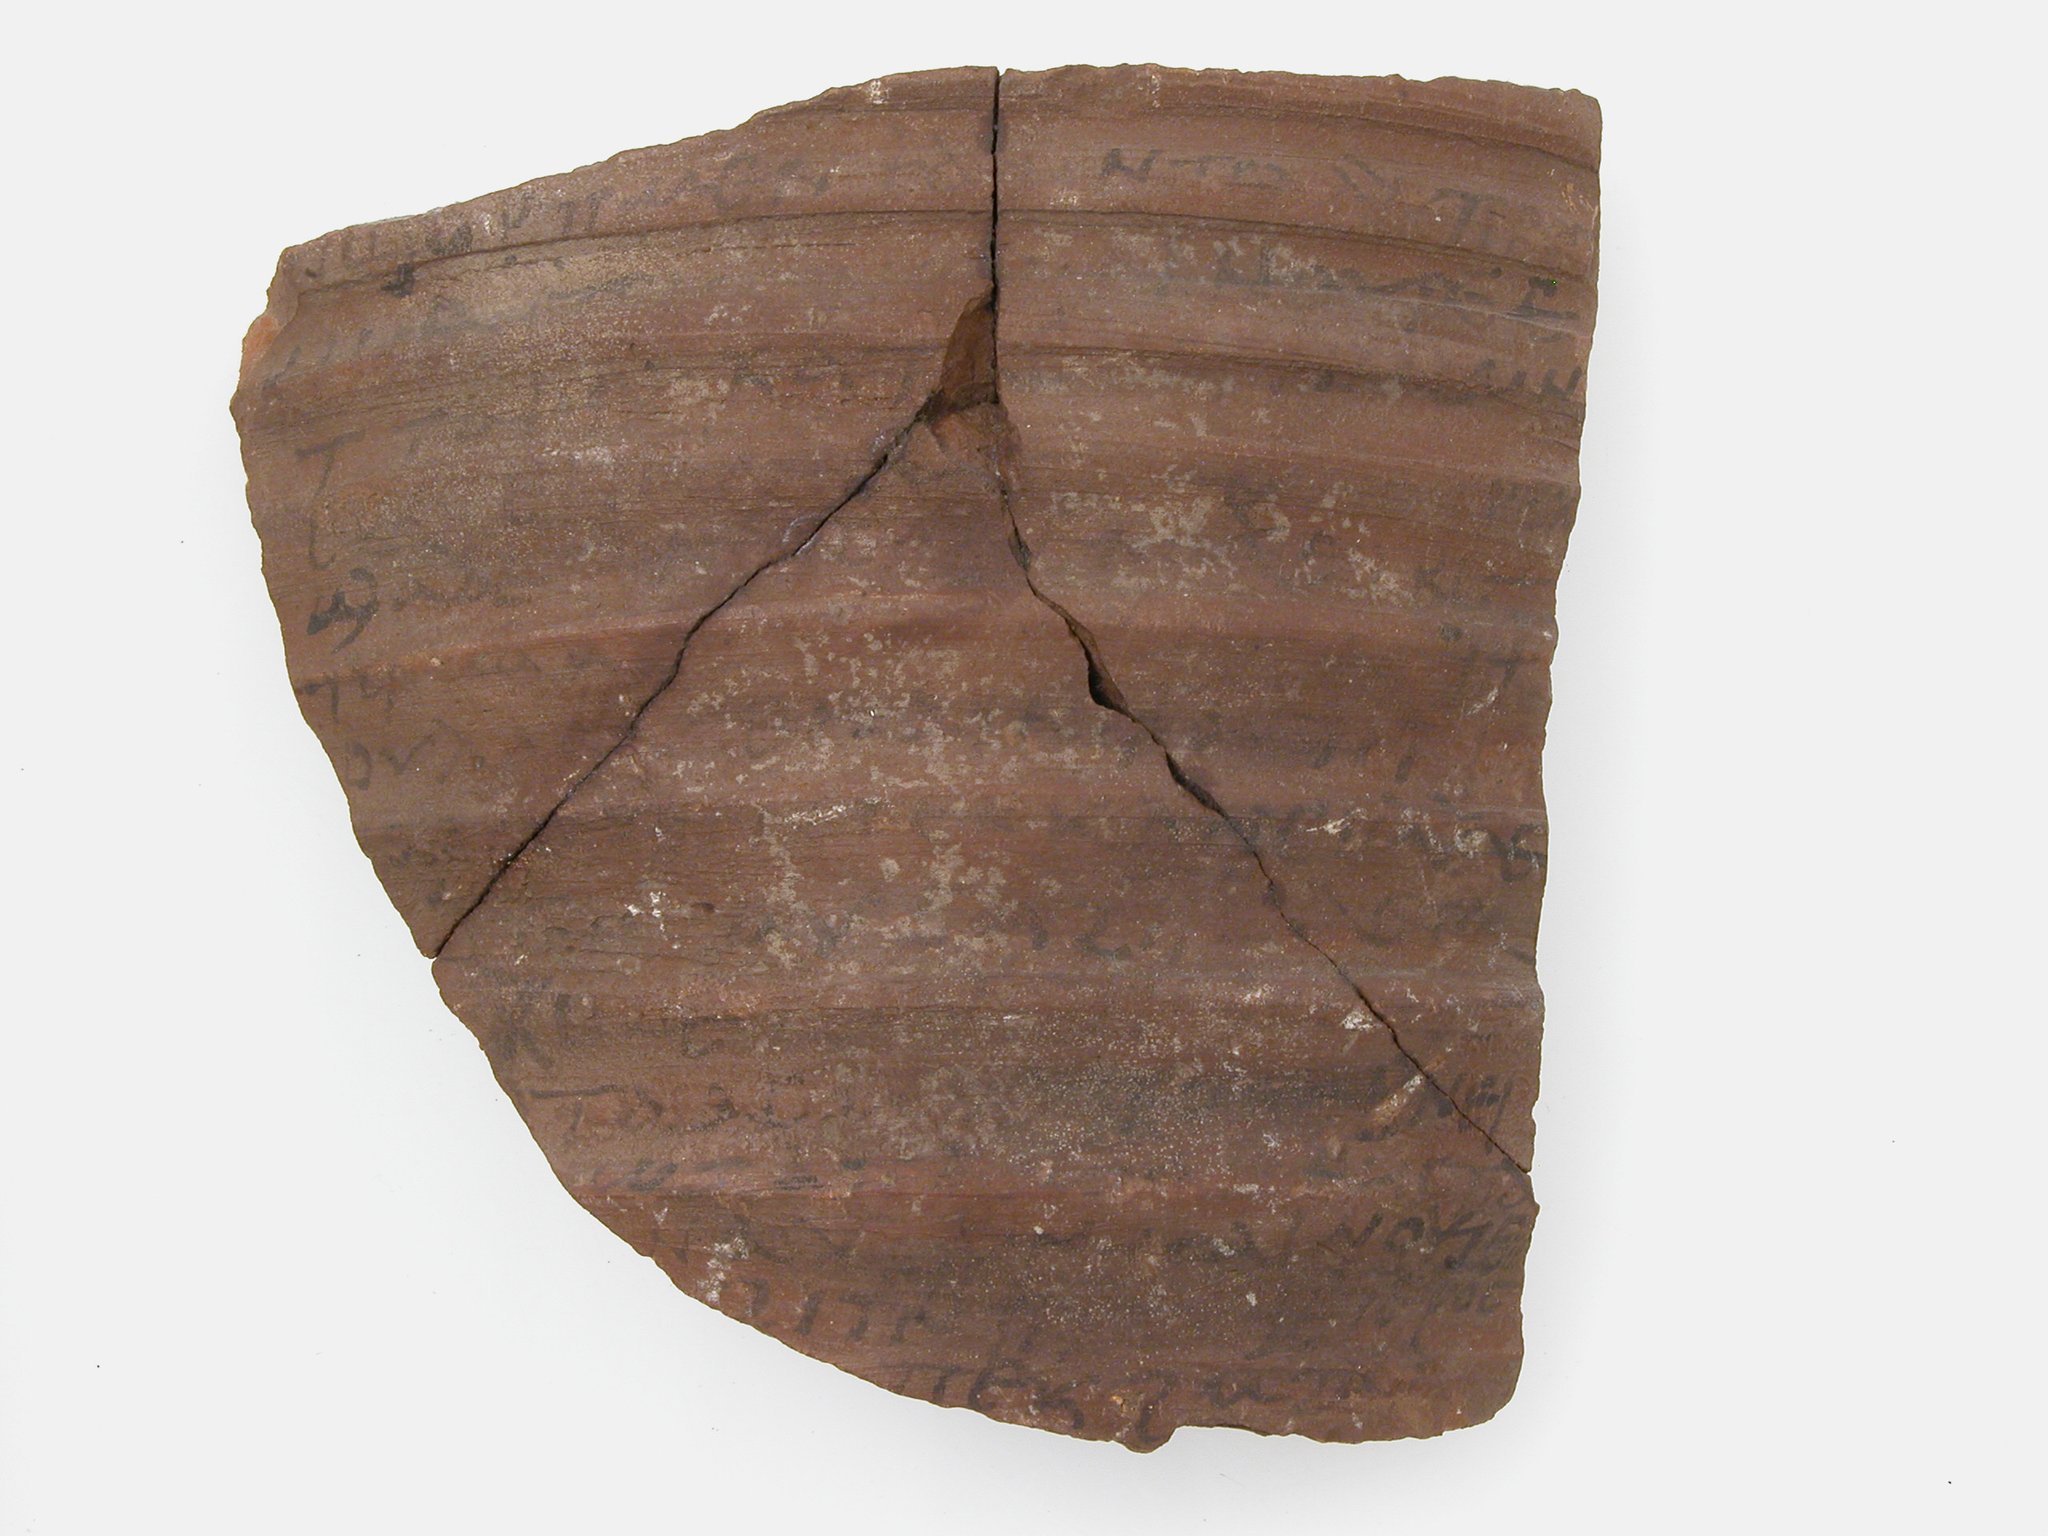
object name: ostrakon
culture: coptic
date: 601-700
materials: ink, pottery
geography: egypt